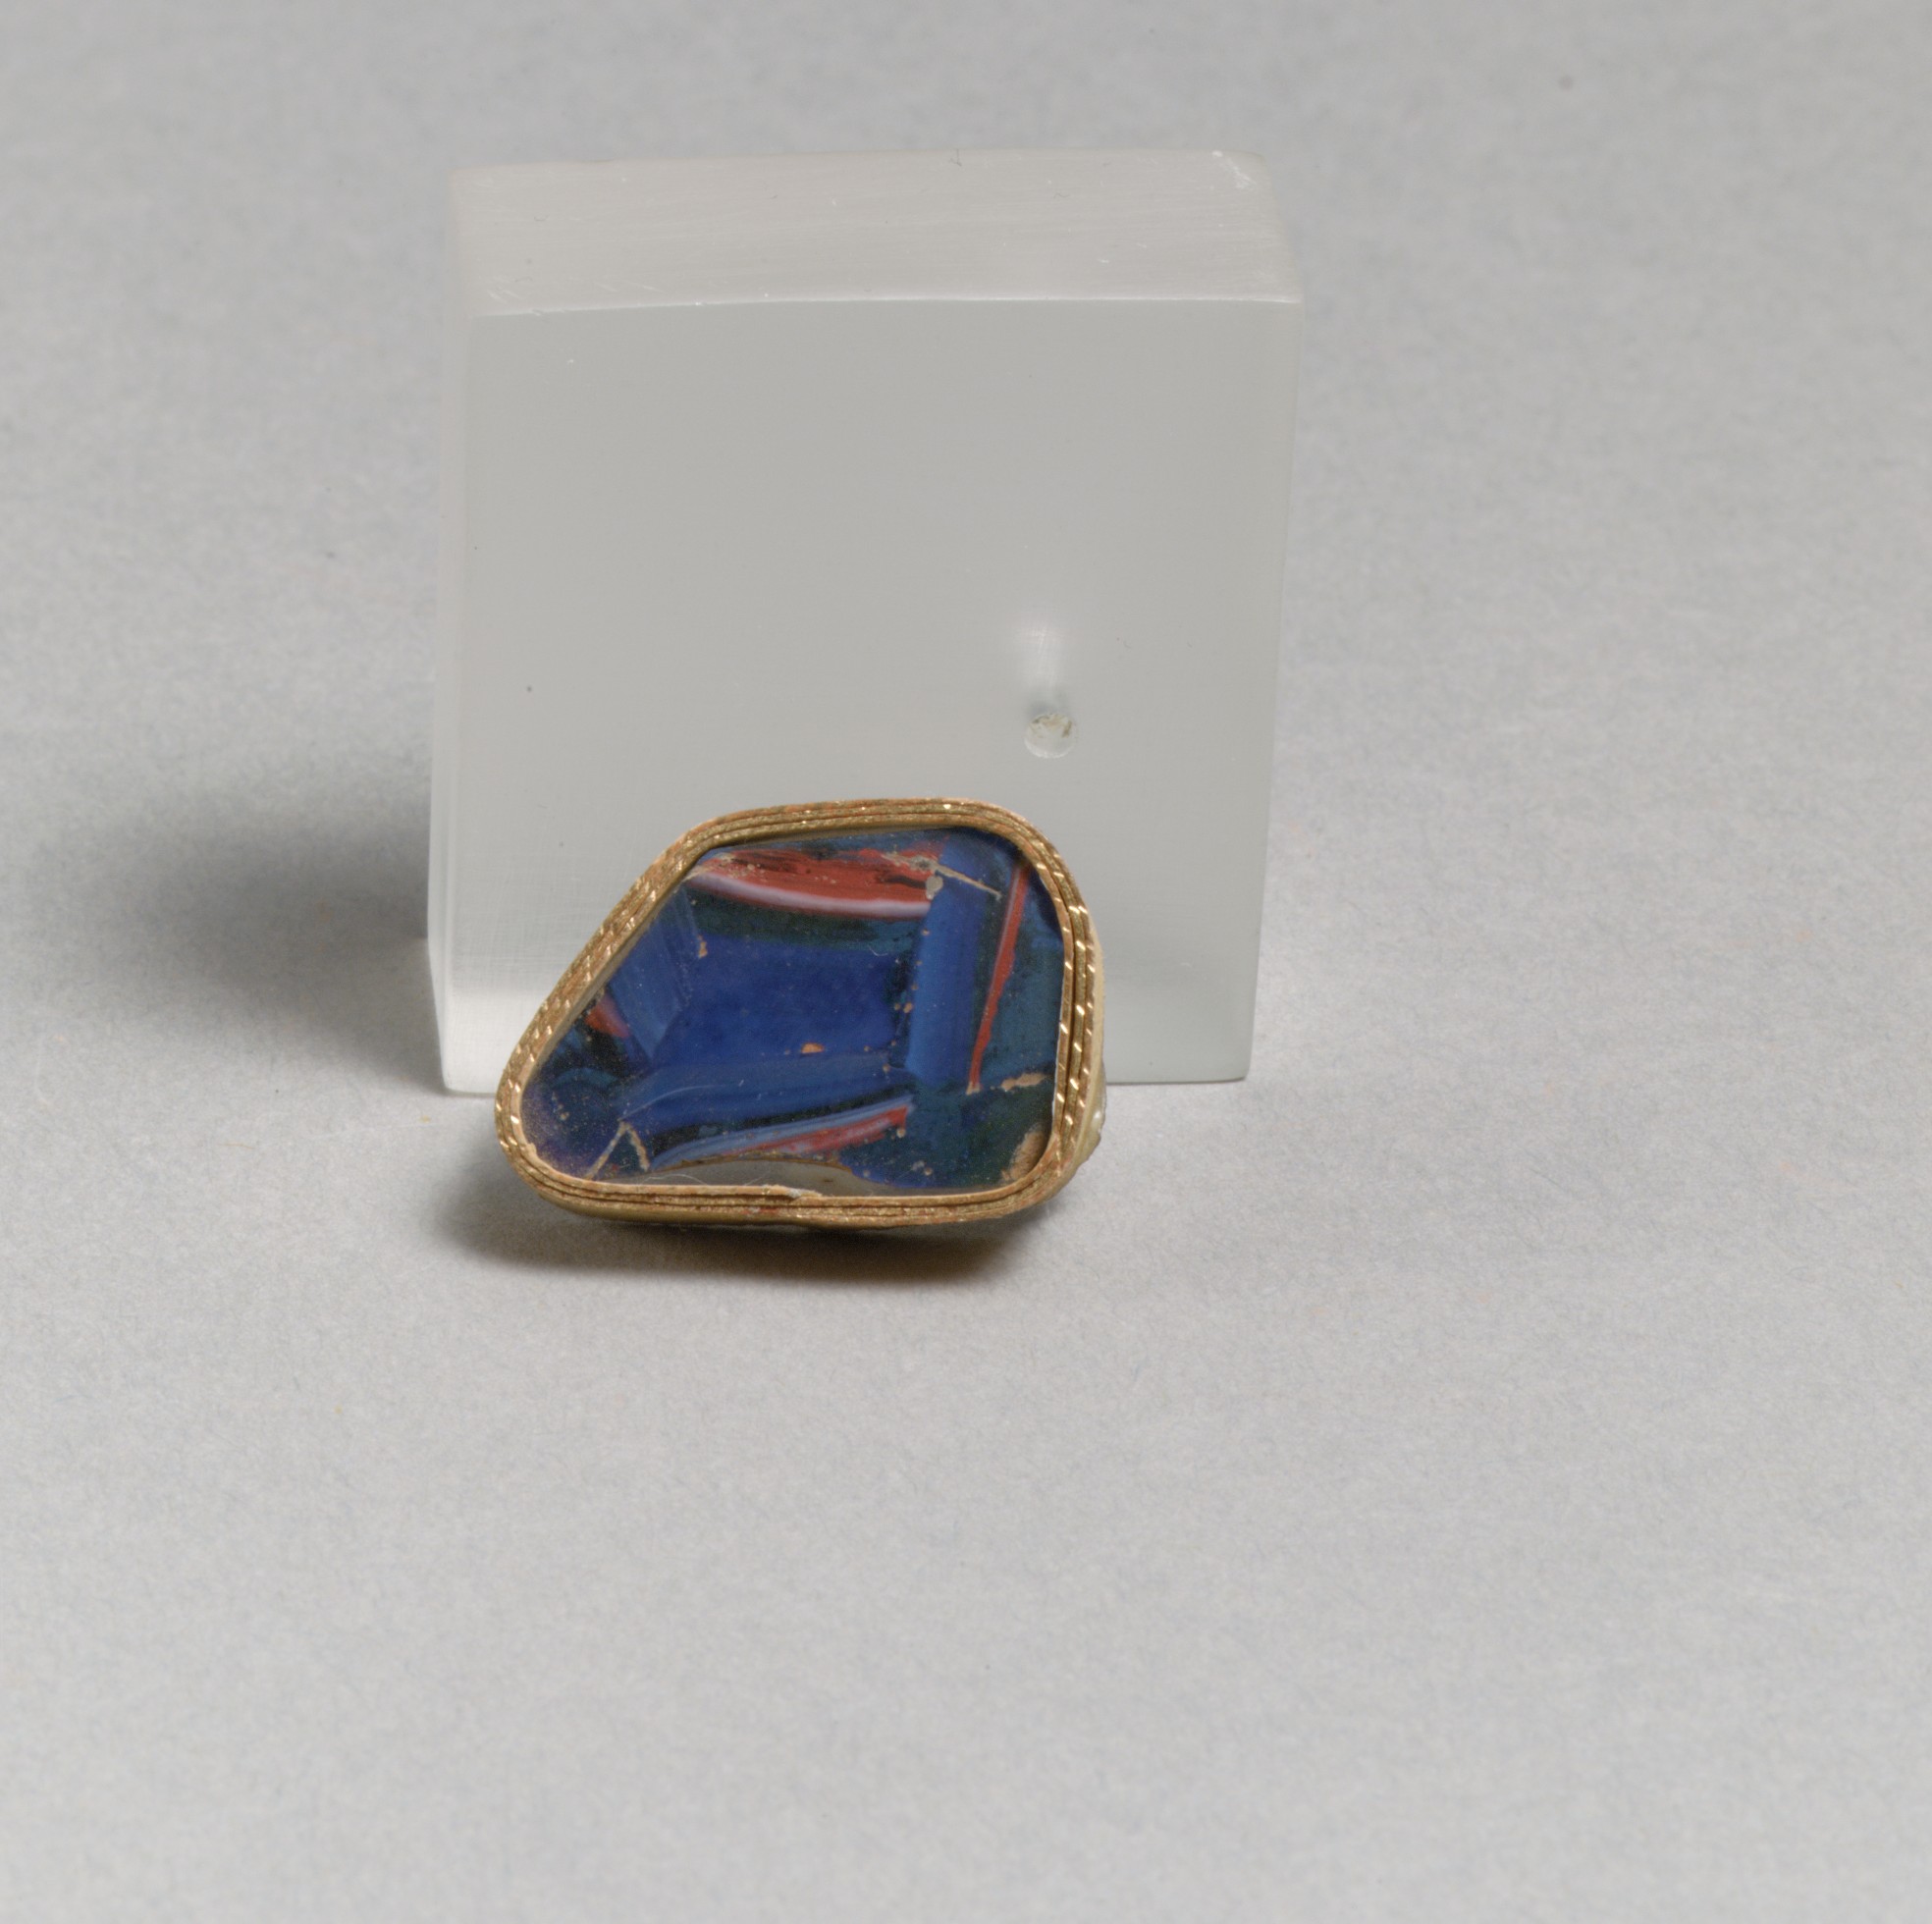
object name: fragment, short strip mosaic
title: Glass short-strip mosaic fragment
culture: roman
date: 34 BCE-33 CE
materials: glass